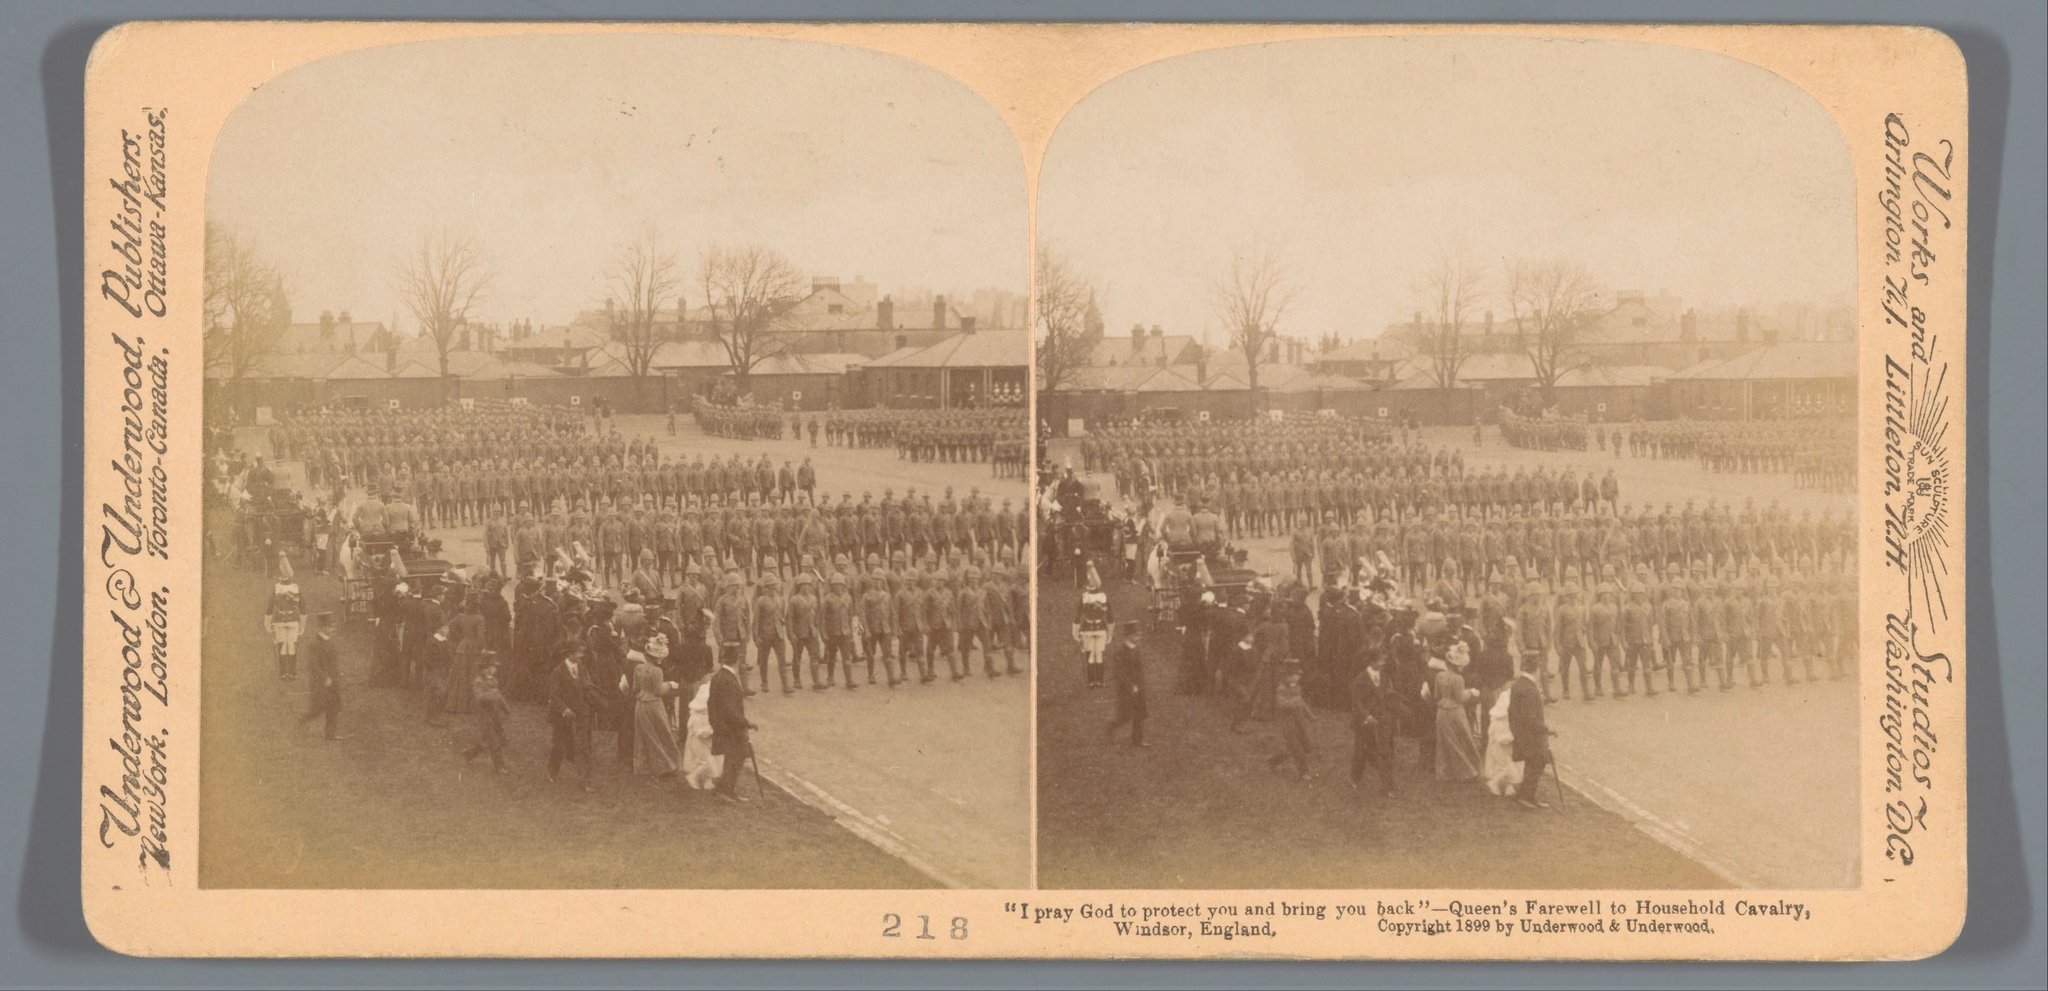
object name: stereograph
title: Parade van de Household Cavalerie voor ze vermoedelijk naar Zuid-Afrika vertrekken voor Victoria van het Verenigd Koninkrijk in Windsor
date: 1899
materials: cardboard, photographic support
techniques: albumen print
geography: windsor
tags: military parade, pageant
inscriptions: number: ‘218’, name: ‘Works and Studios Sun Sculpture trade mark Arlington N.J. Littleton N.H. Washington D.C.’